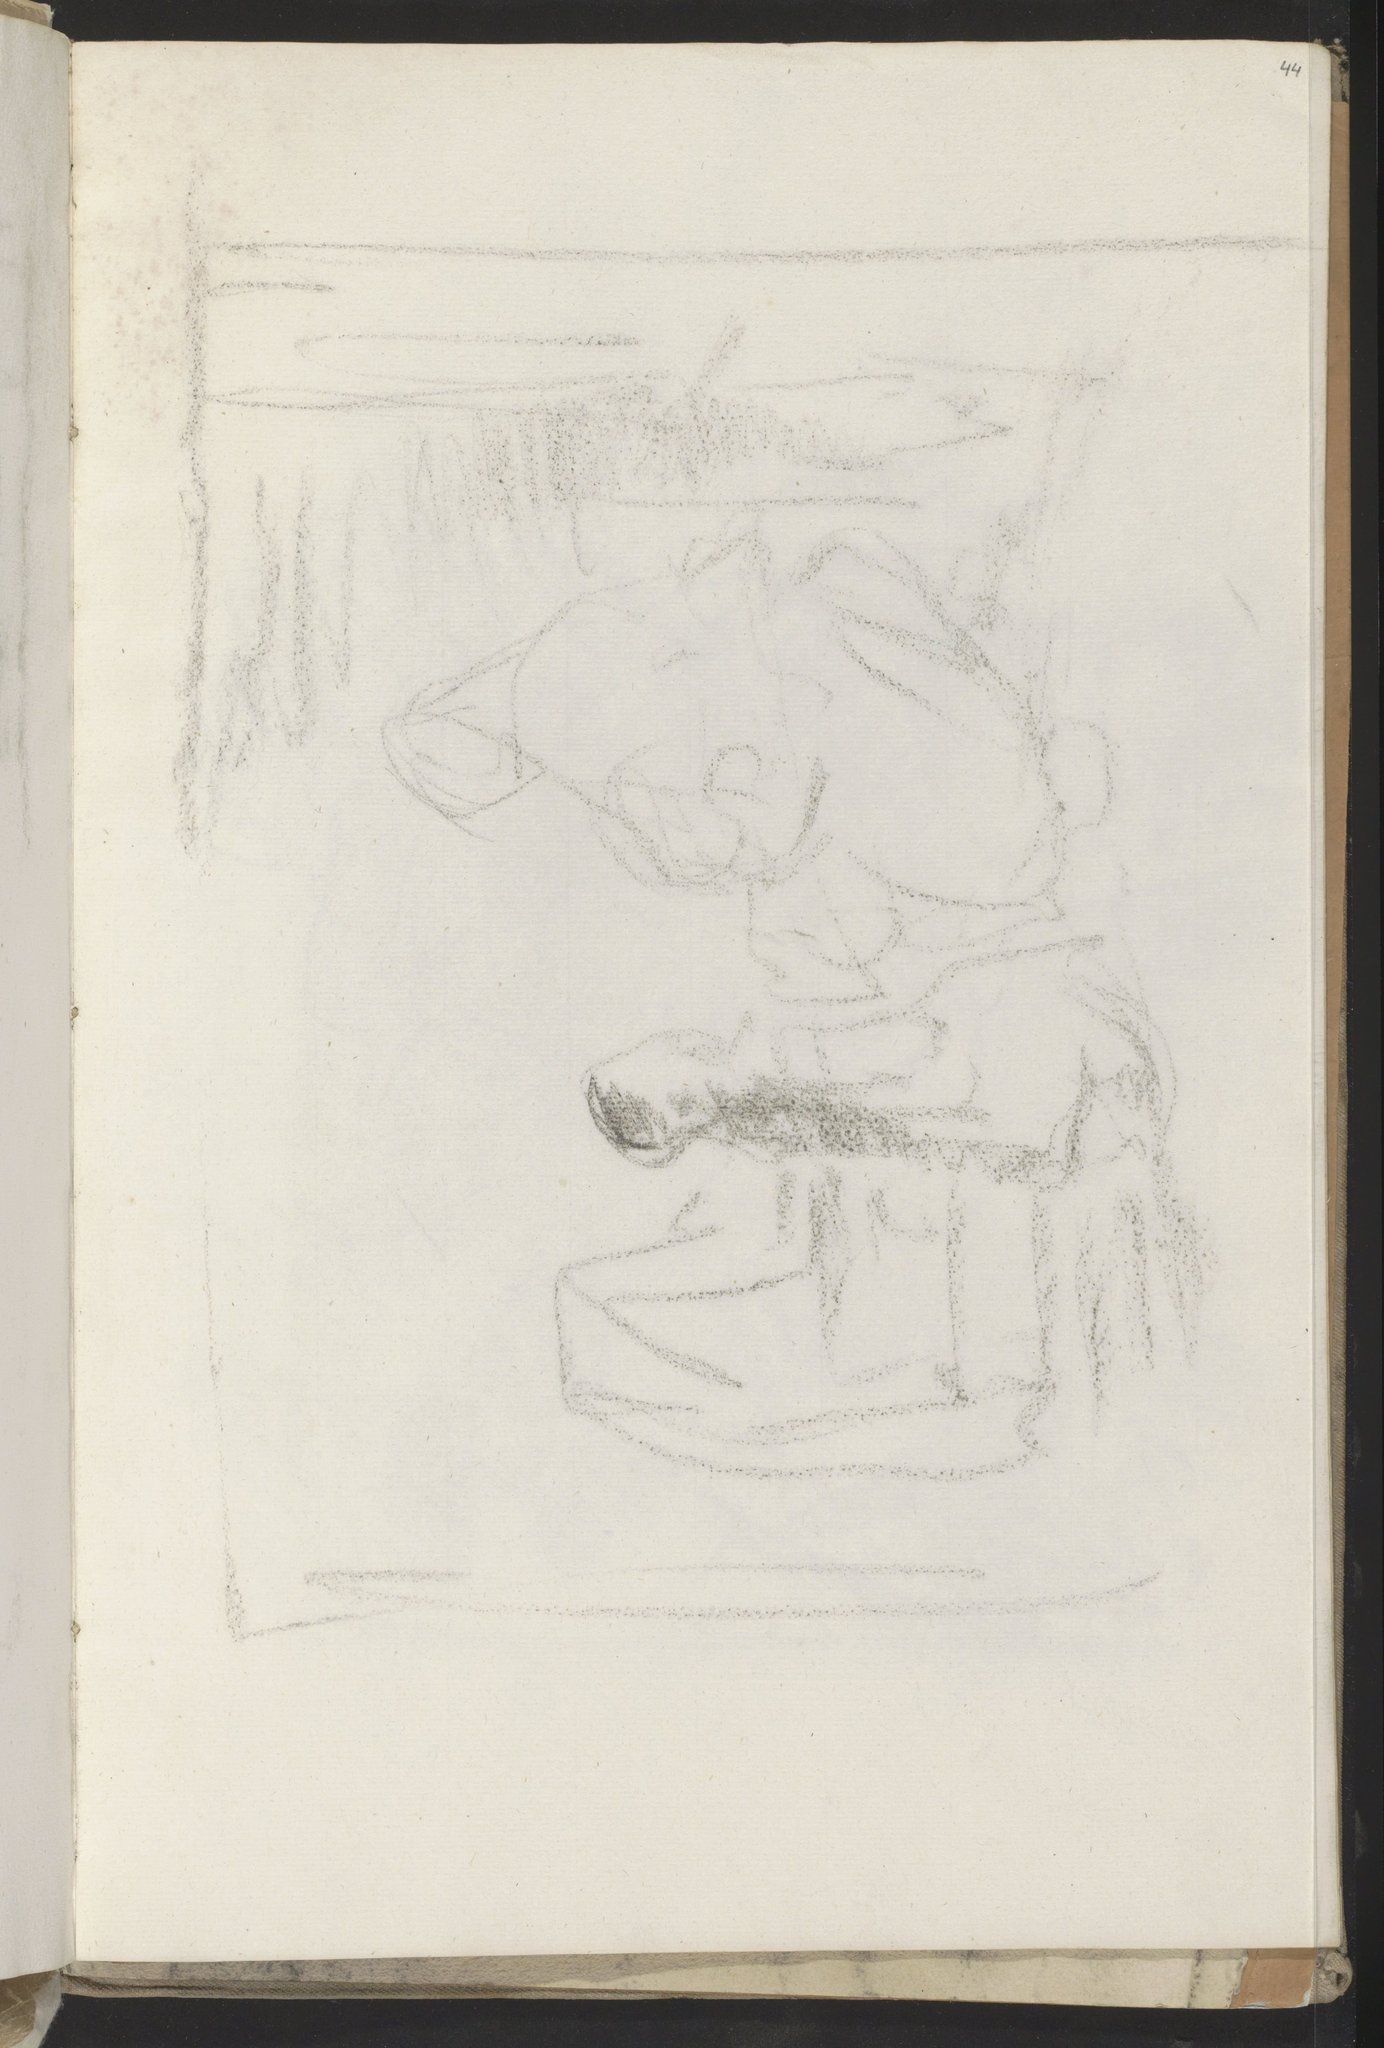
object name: sketchbook leaf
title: Vrouw en kind bij een wieg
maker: albert neuhuys (1844-1914)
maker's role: draughtsman, painter, print maker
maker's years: 1844-1914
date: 1854-1914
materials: charcoal, paper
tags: sitting figure, adult woman, child, cradle, crib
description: Blad 44 recto uit een schetsboek met 53 bladen.